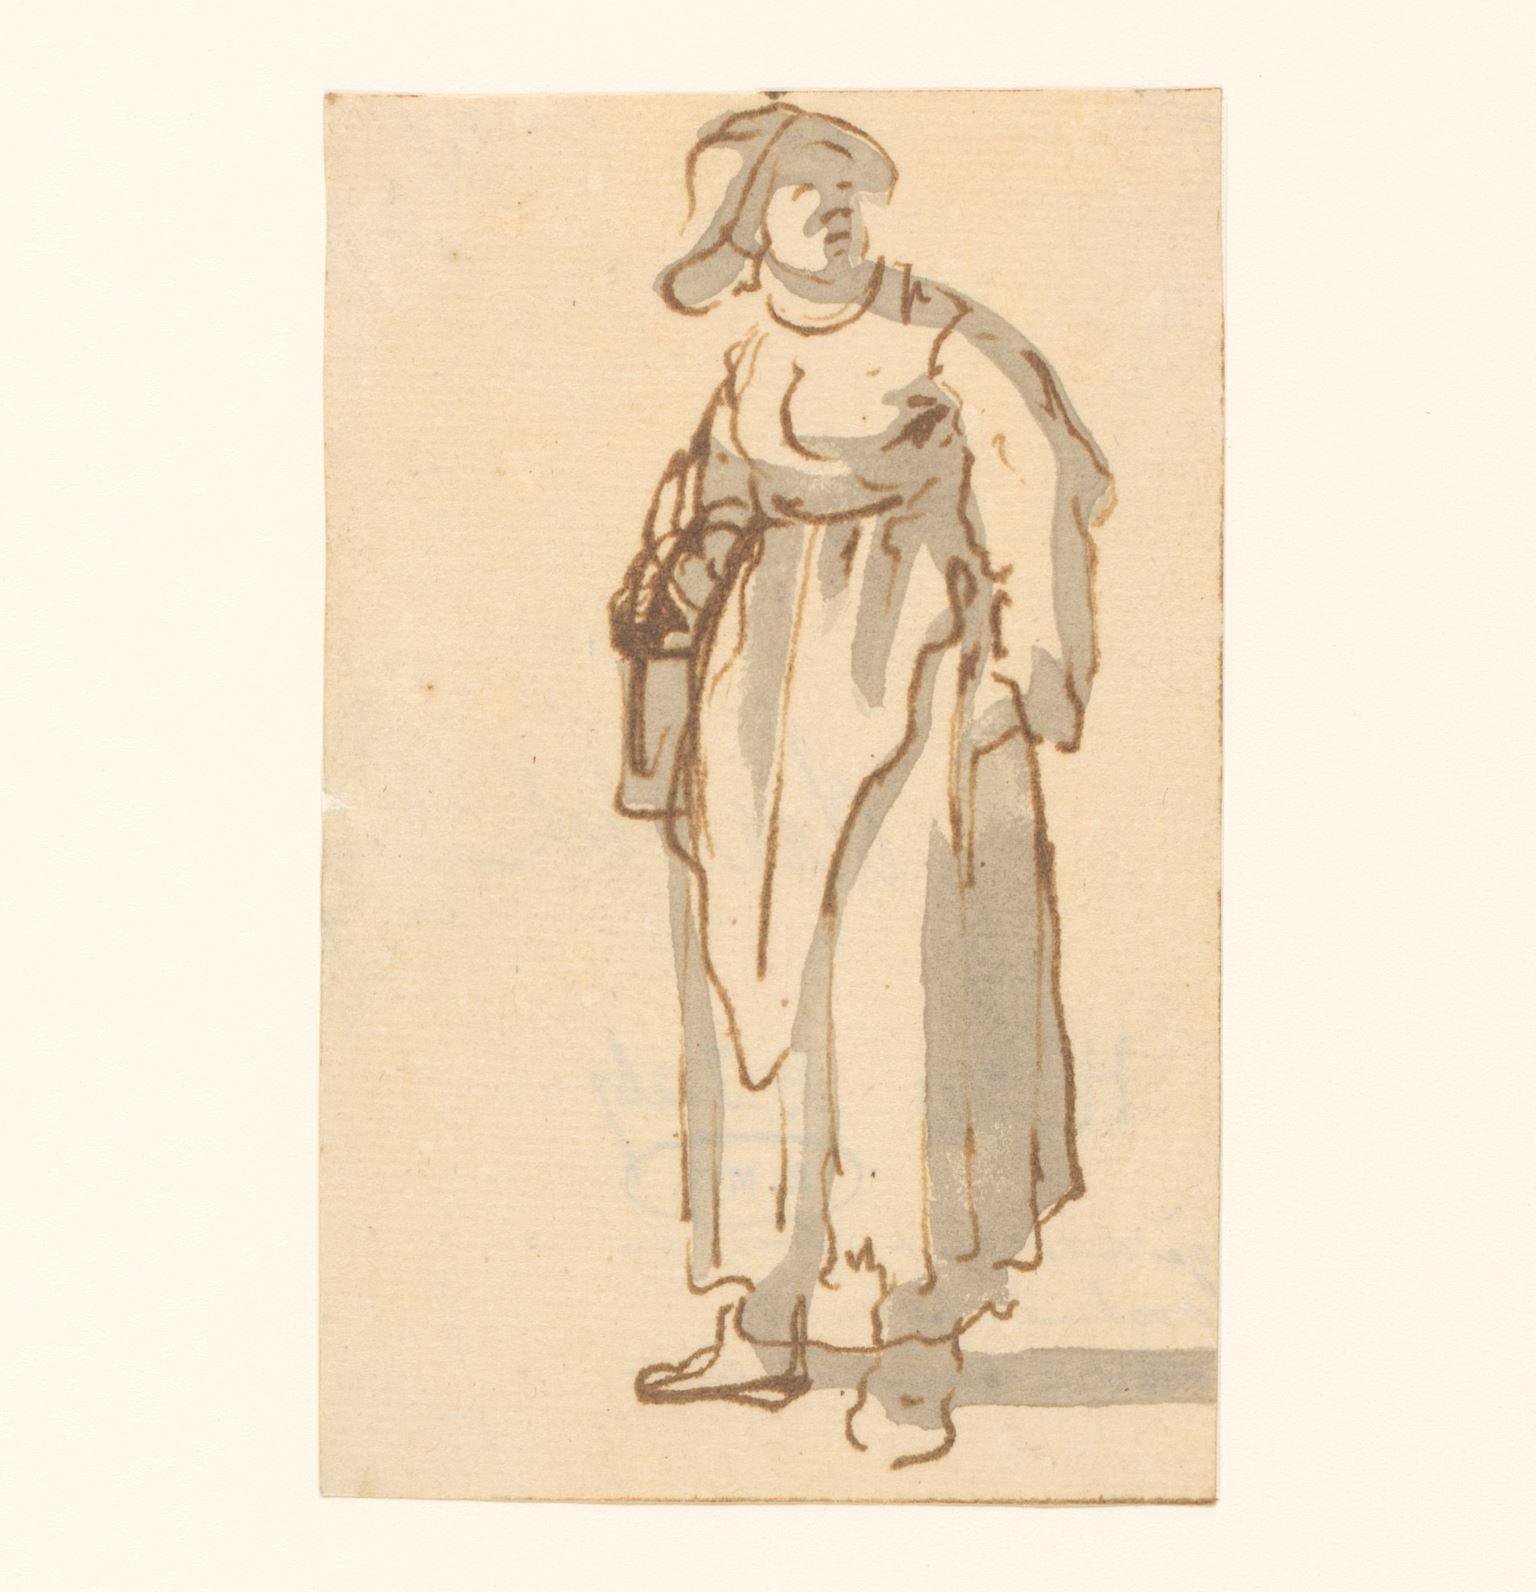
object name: print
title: Staande boerin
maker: ernst willem jan bagelaar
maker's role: draughtsman, print maker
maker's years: 1775-1837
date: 1785-1837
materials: paper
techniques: printing, etching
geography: netherlands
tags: farmers - aa - female farmer, farmer's wife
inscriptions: inscription: ‘gedrukt met west en/ oostindische inkt/ Z.W.J. Bagelaar fecit’, collector's mark: Lugt 2228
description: Naar een tekening door Breckerveld uit 1668, zie Delineavit et sculpsit, nr. 23, juli 2001 en RKD nr. 42914.